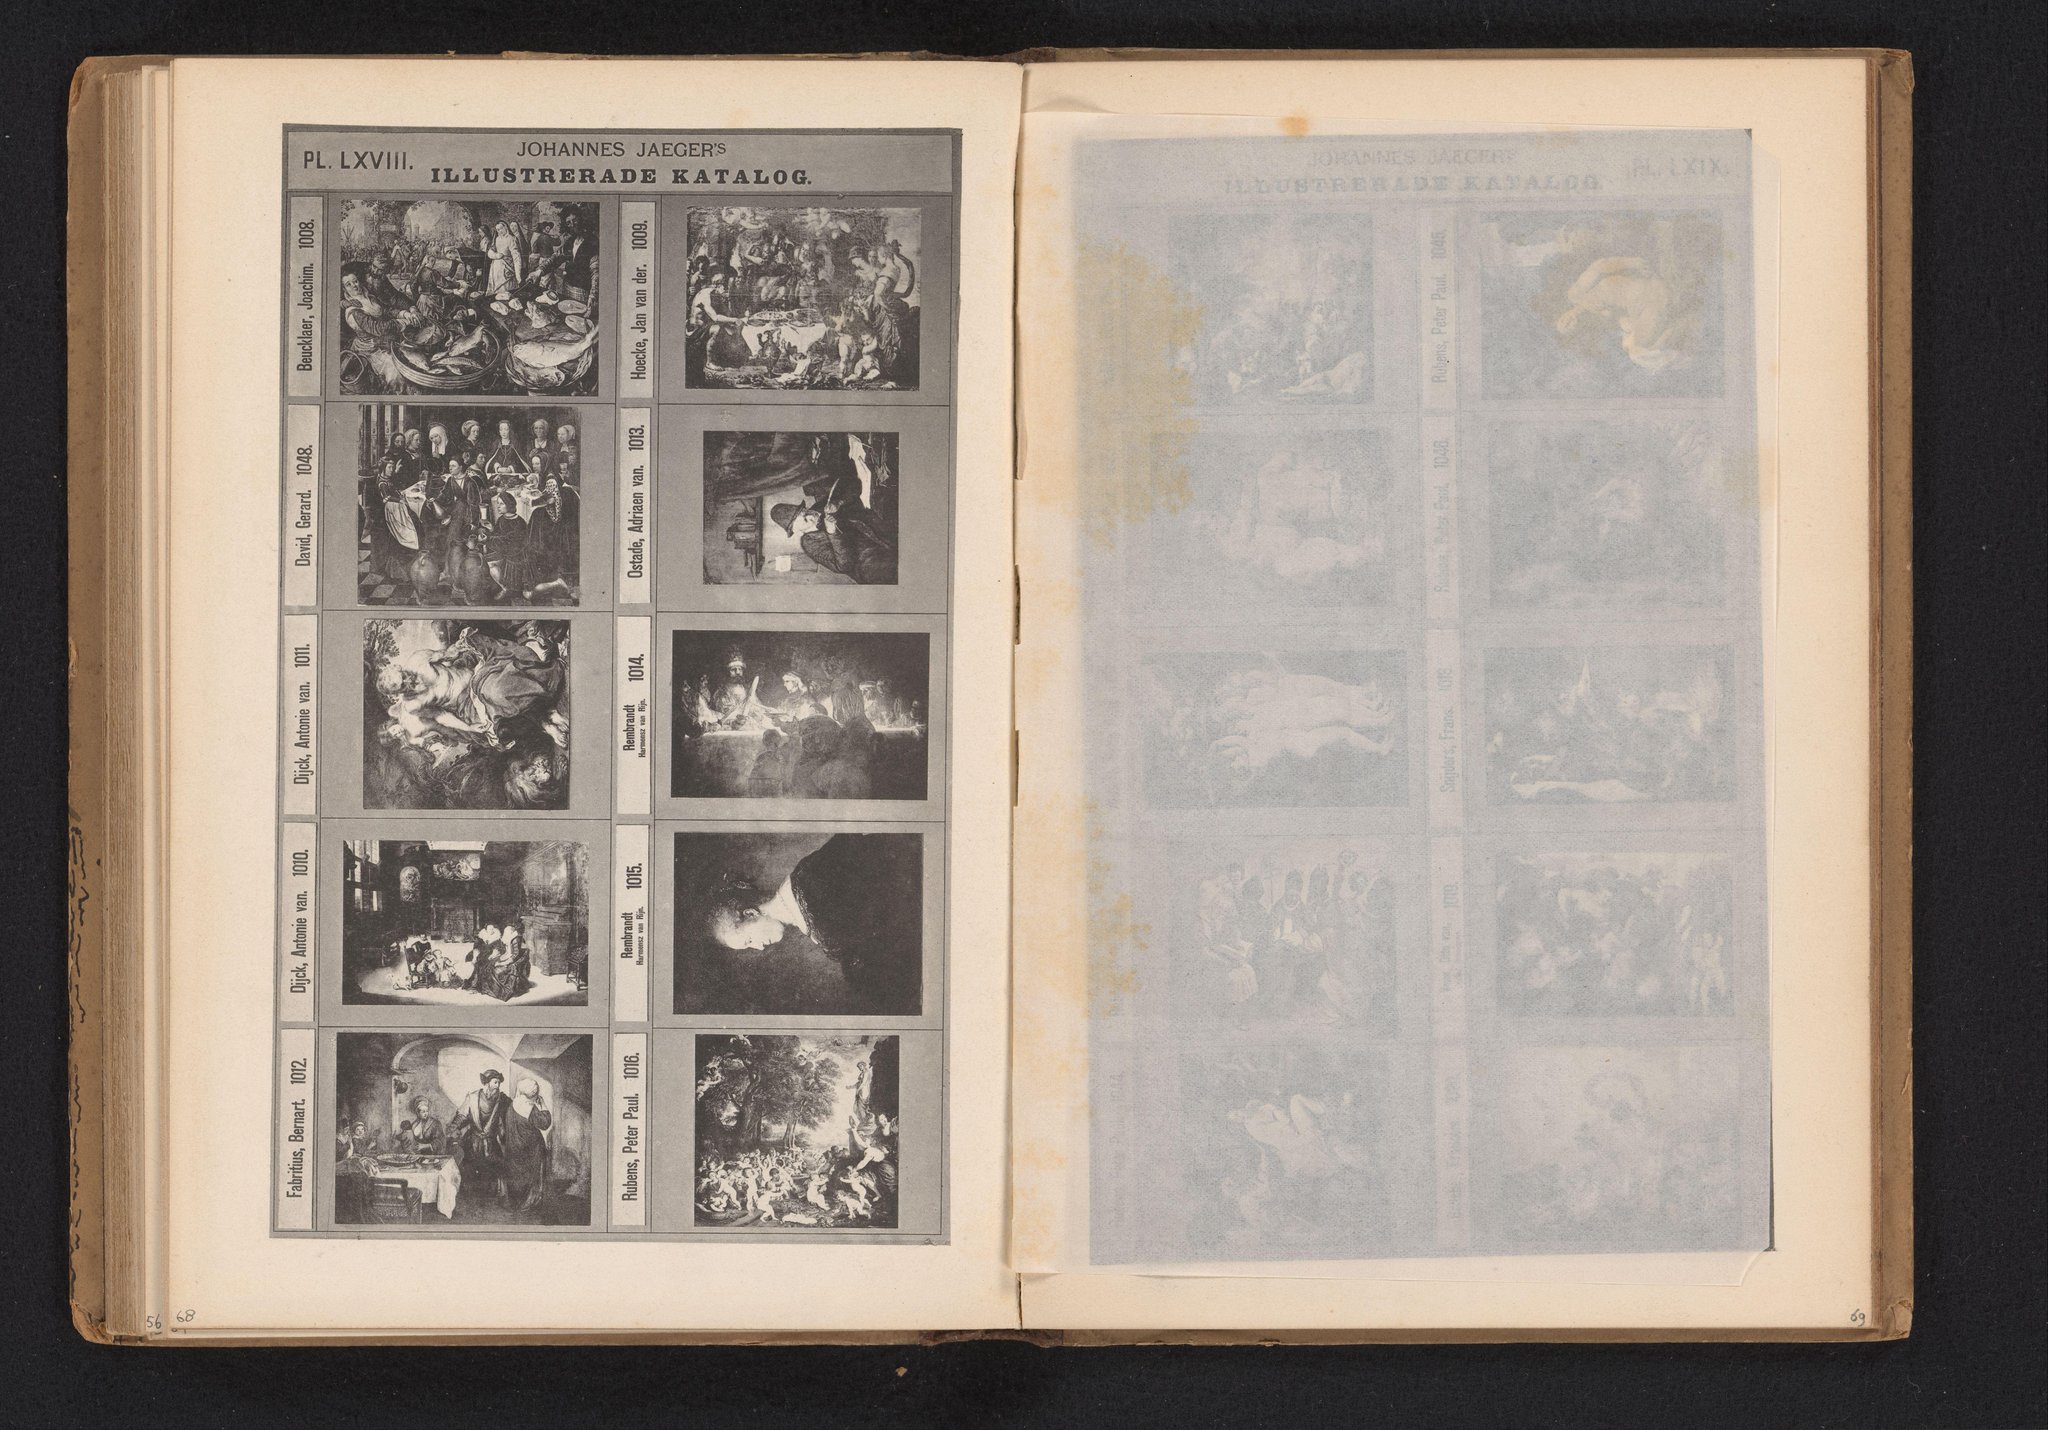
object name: photomechanical print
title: Johannes Jaeger's Illustrerade Katalog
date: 1872-1882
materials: paper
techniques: photograph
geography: stockholm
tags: picture, painting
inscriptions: number: ‘PL. LXVIII.’